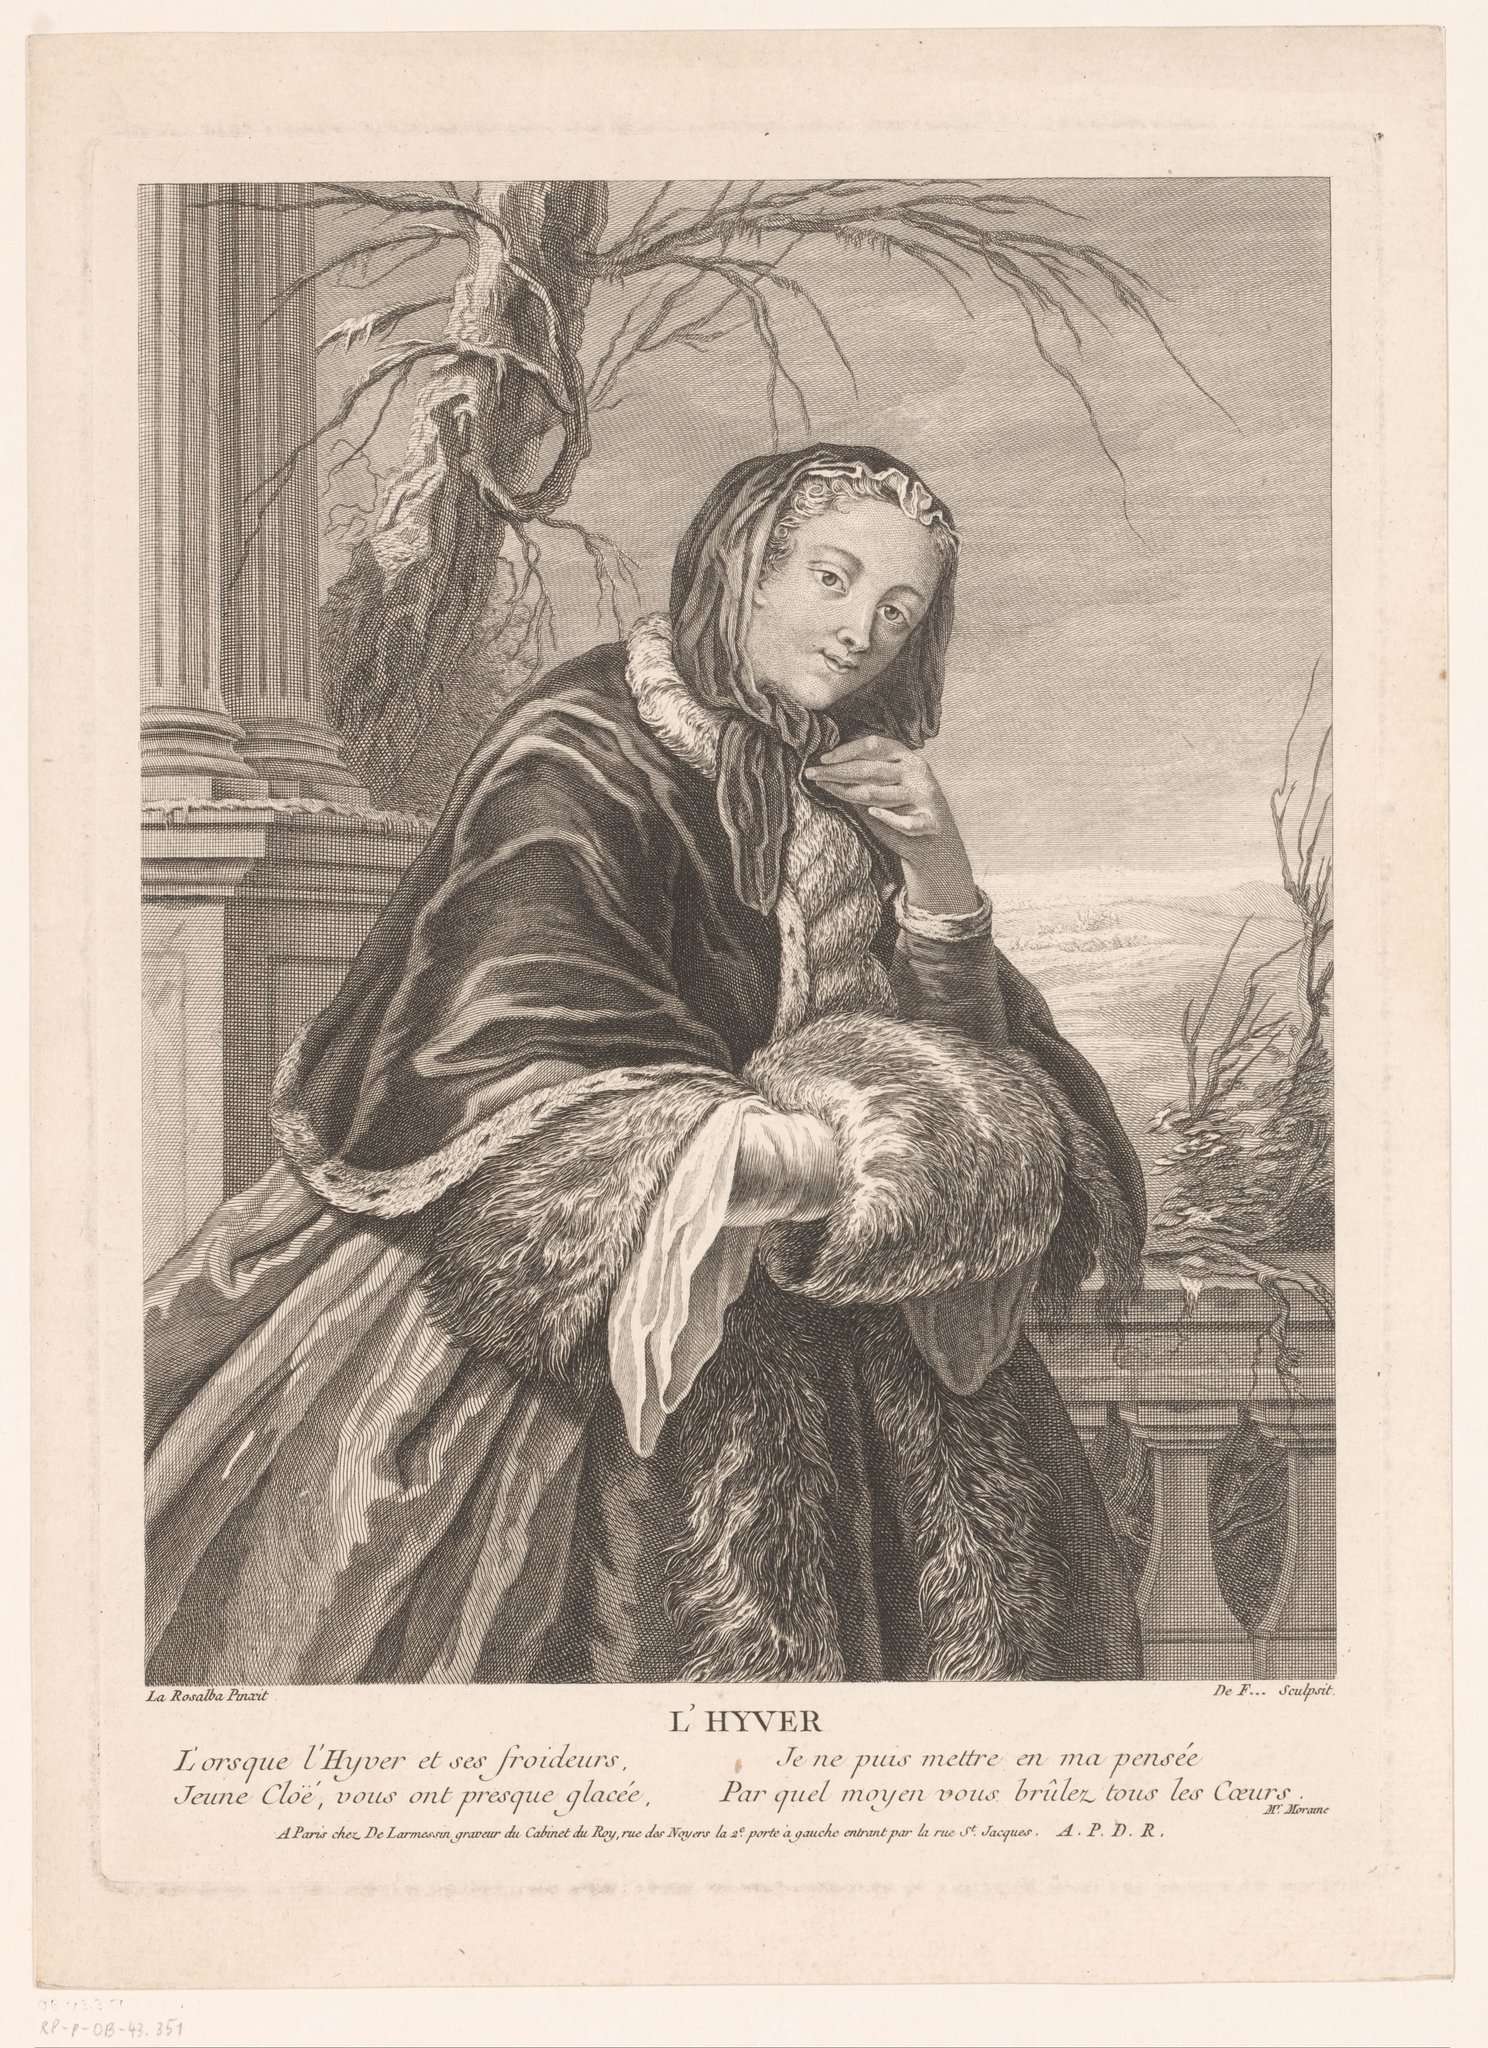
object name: print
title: Personificatie van de winter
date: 1733-1755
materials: paper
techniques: engraving, etching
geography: paris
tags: adult woman, winter, 'hyems'; 'inverno' (ripa)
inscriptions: collector's mark: Lugt 2228